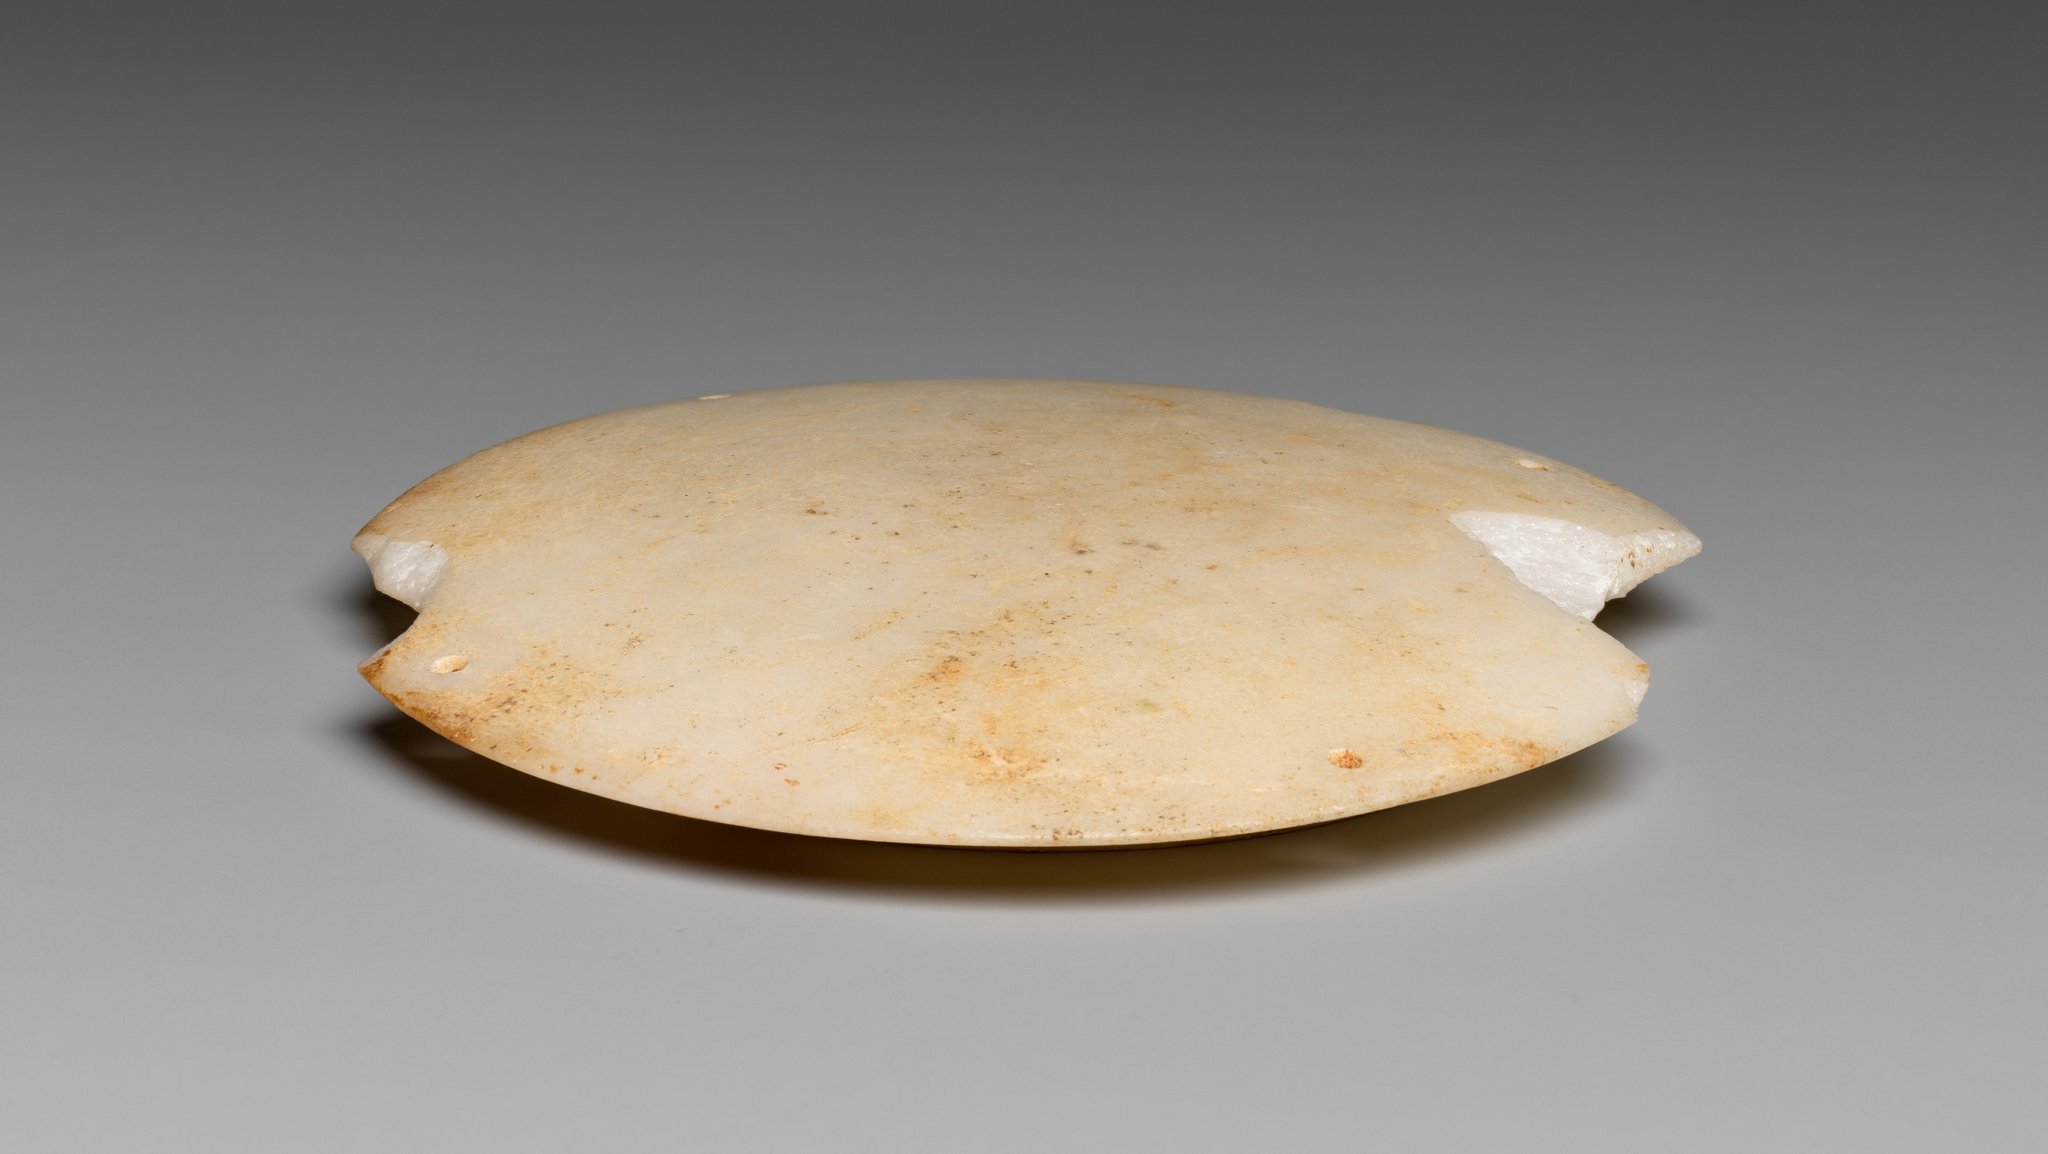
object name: pyxis with lid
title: Marble lid of a spool pyxis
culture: cycladic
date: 2700-2200 BCE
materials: marble